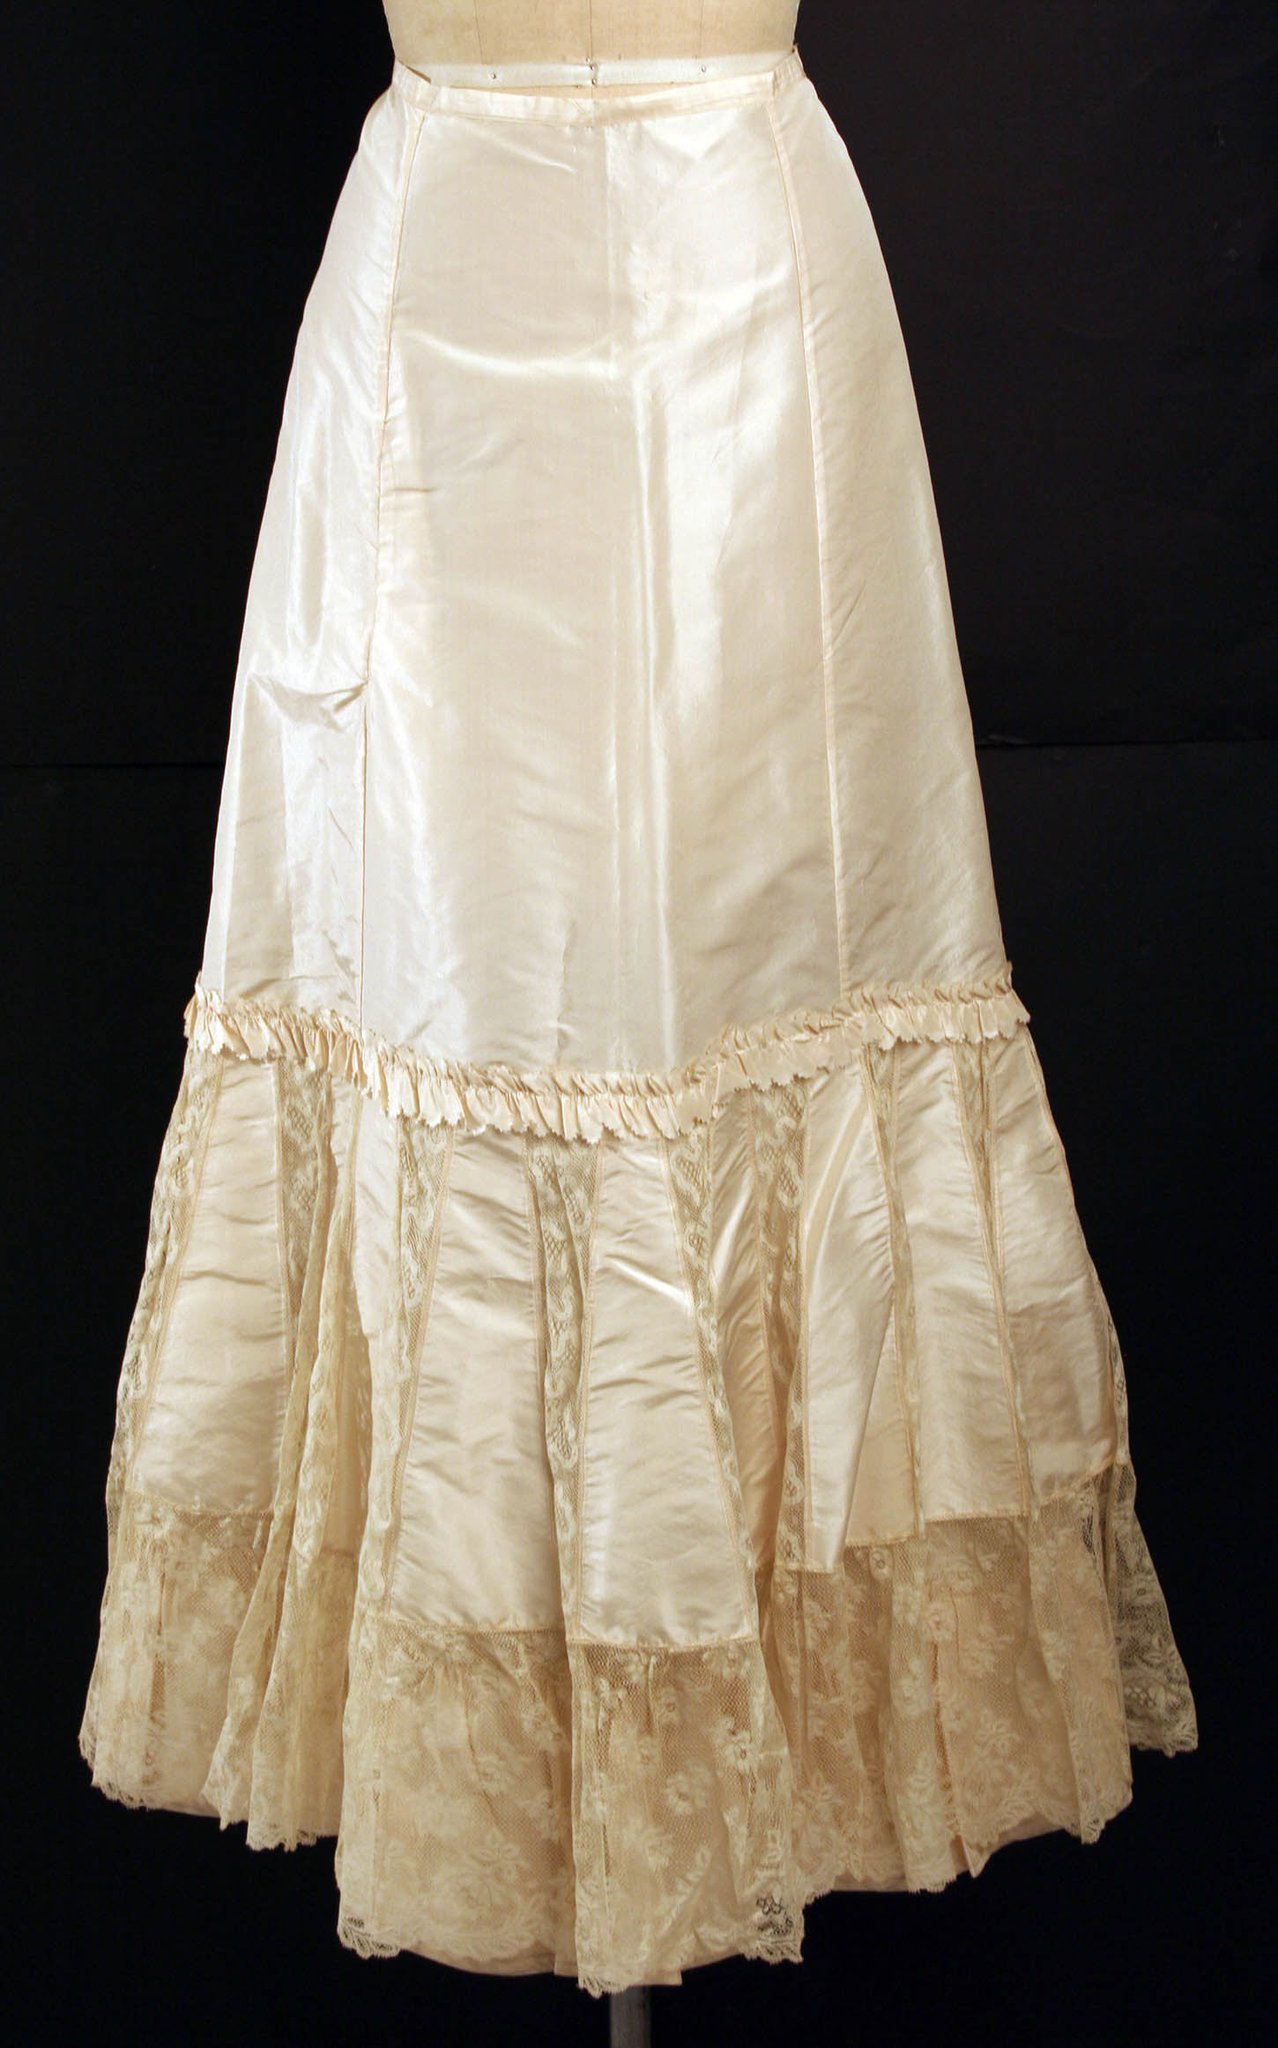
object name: petticoat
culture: american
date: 1890-1899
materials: silk